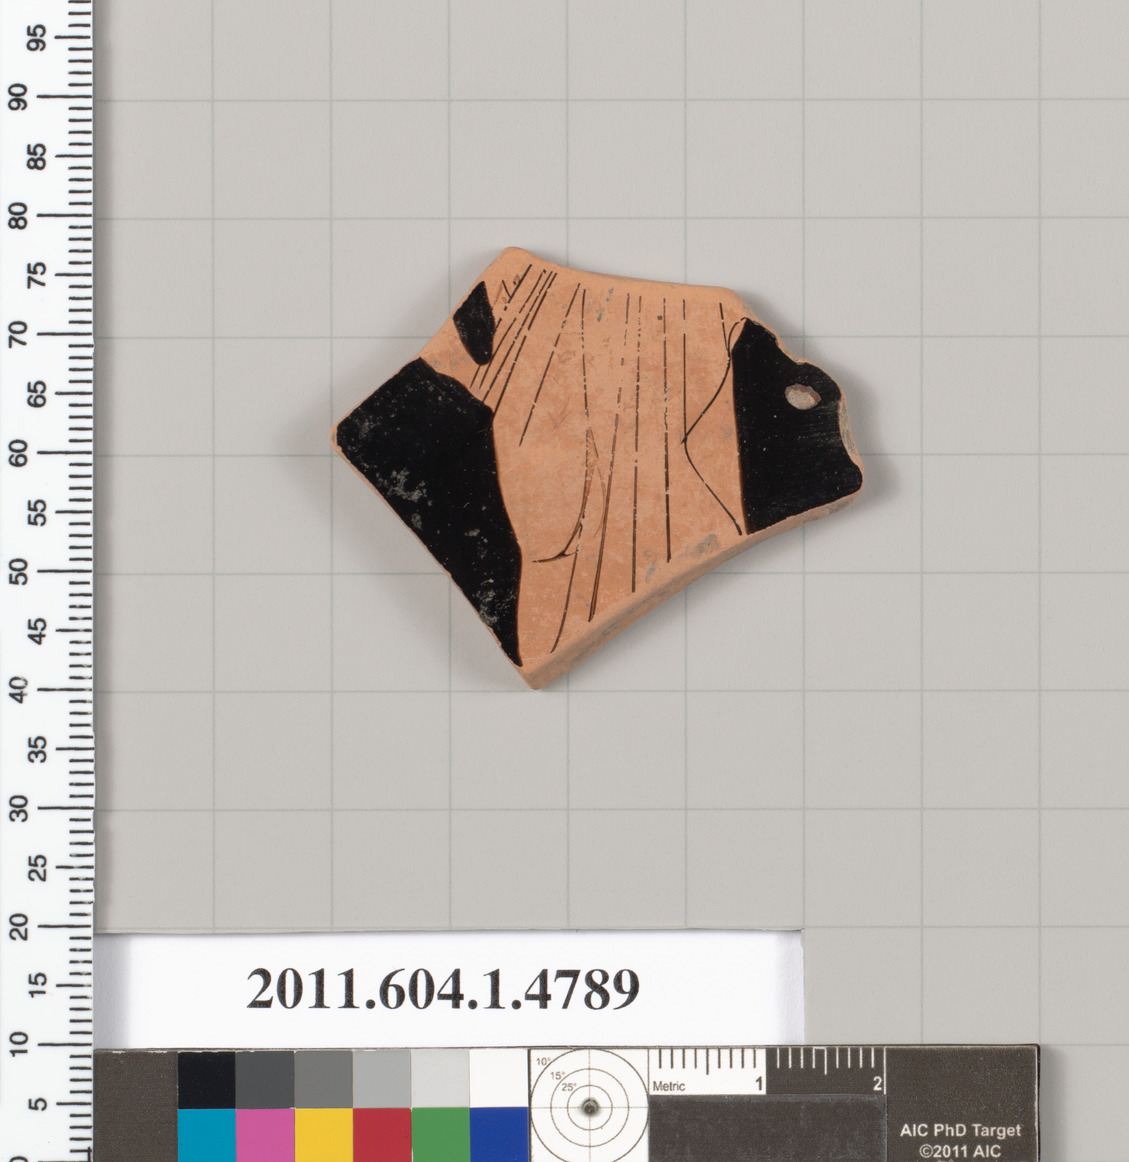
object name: kylix fragment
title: Terracotta fragment of a kylix (drinking cup)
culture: greek, attic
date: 475-451 BCE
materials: terracotta